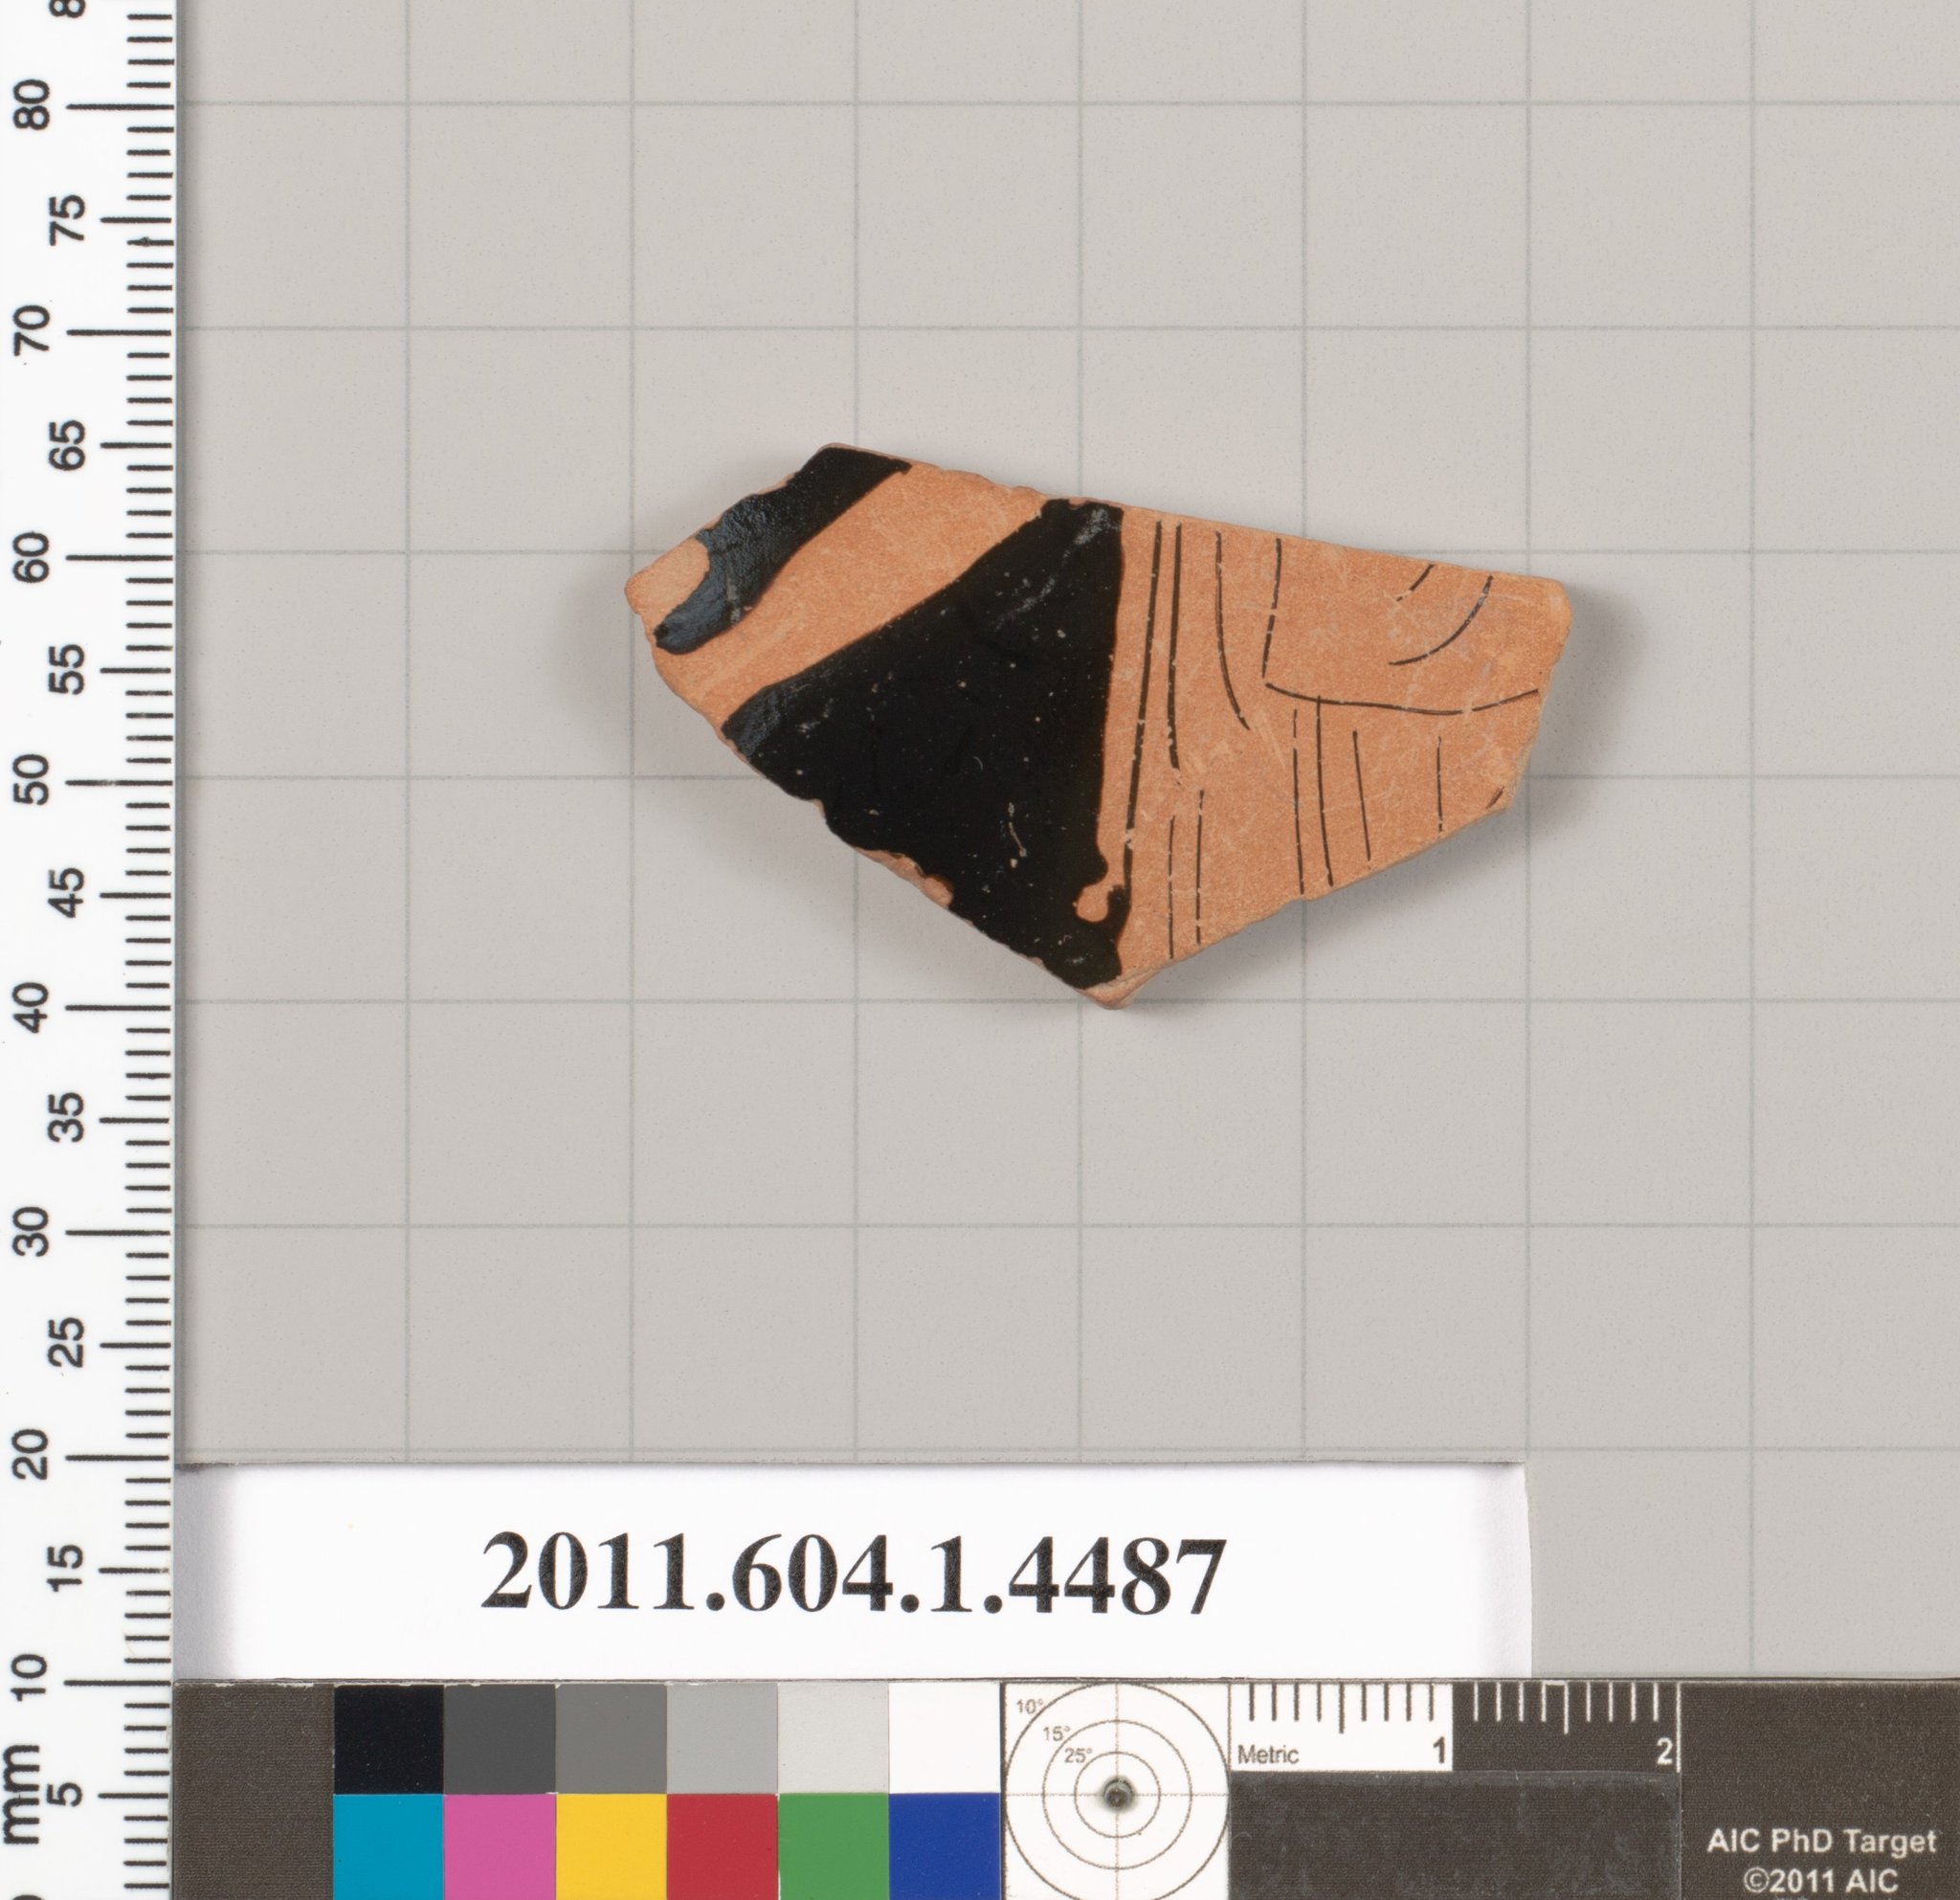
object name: kylix fragment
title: Terracotta fragment of a kylix (drinking cup)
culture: greek, attic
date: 475-451 BCE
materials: terracotta